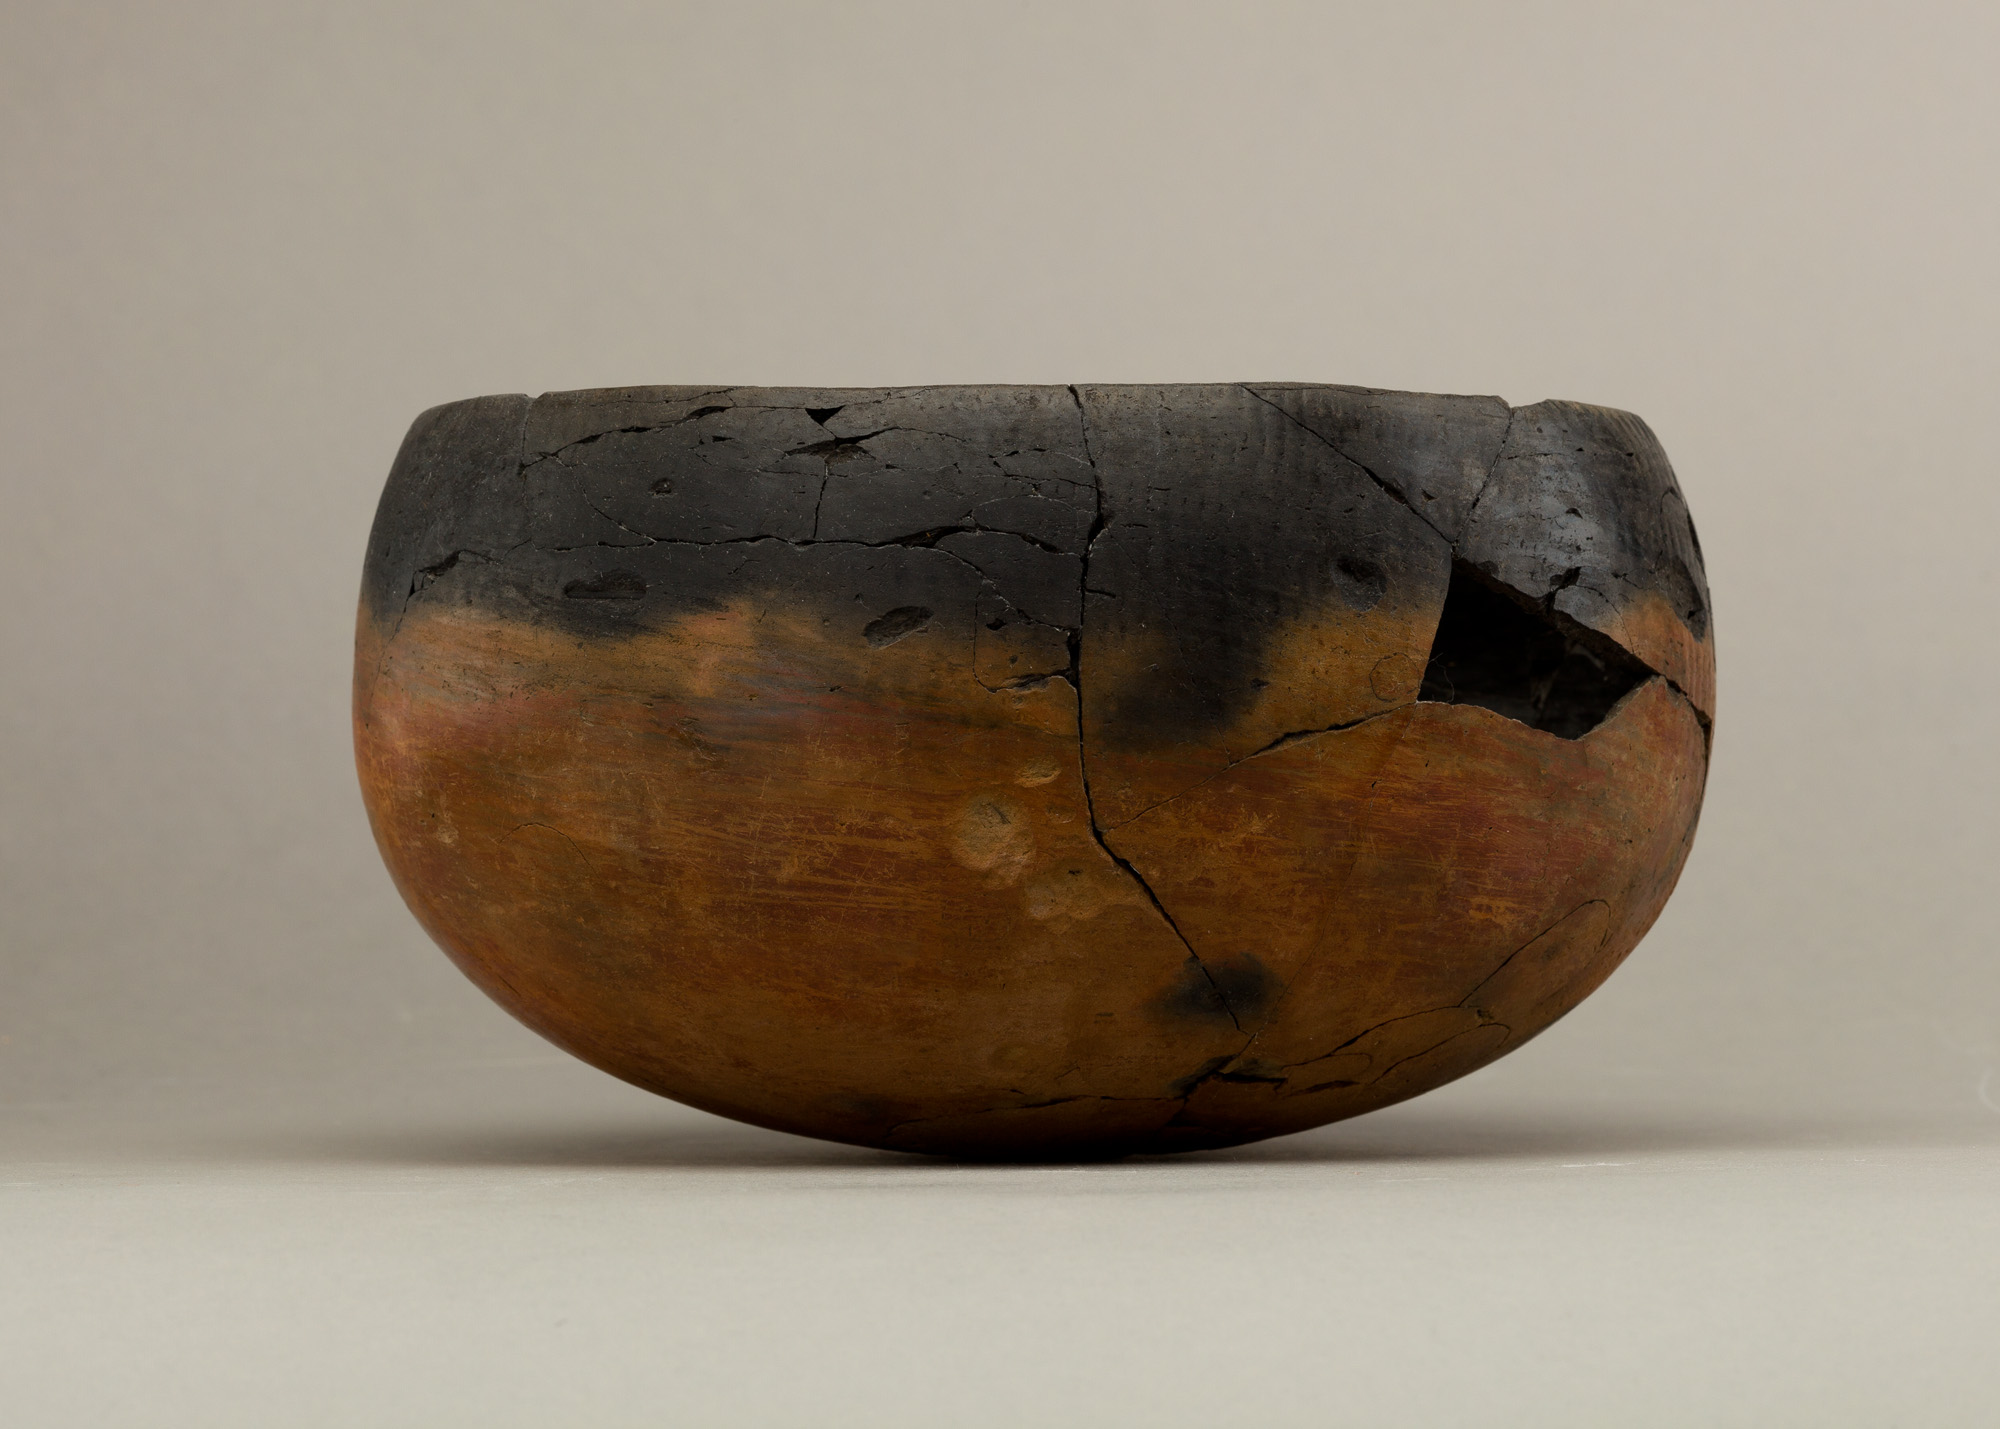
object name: bowl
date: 4400-3800 BCE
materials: pottery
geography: egypt